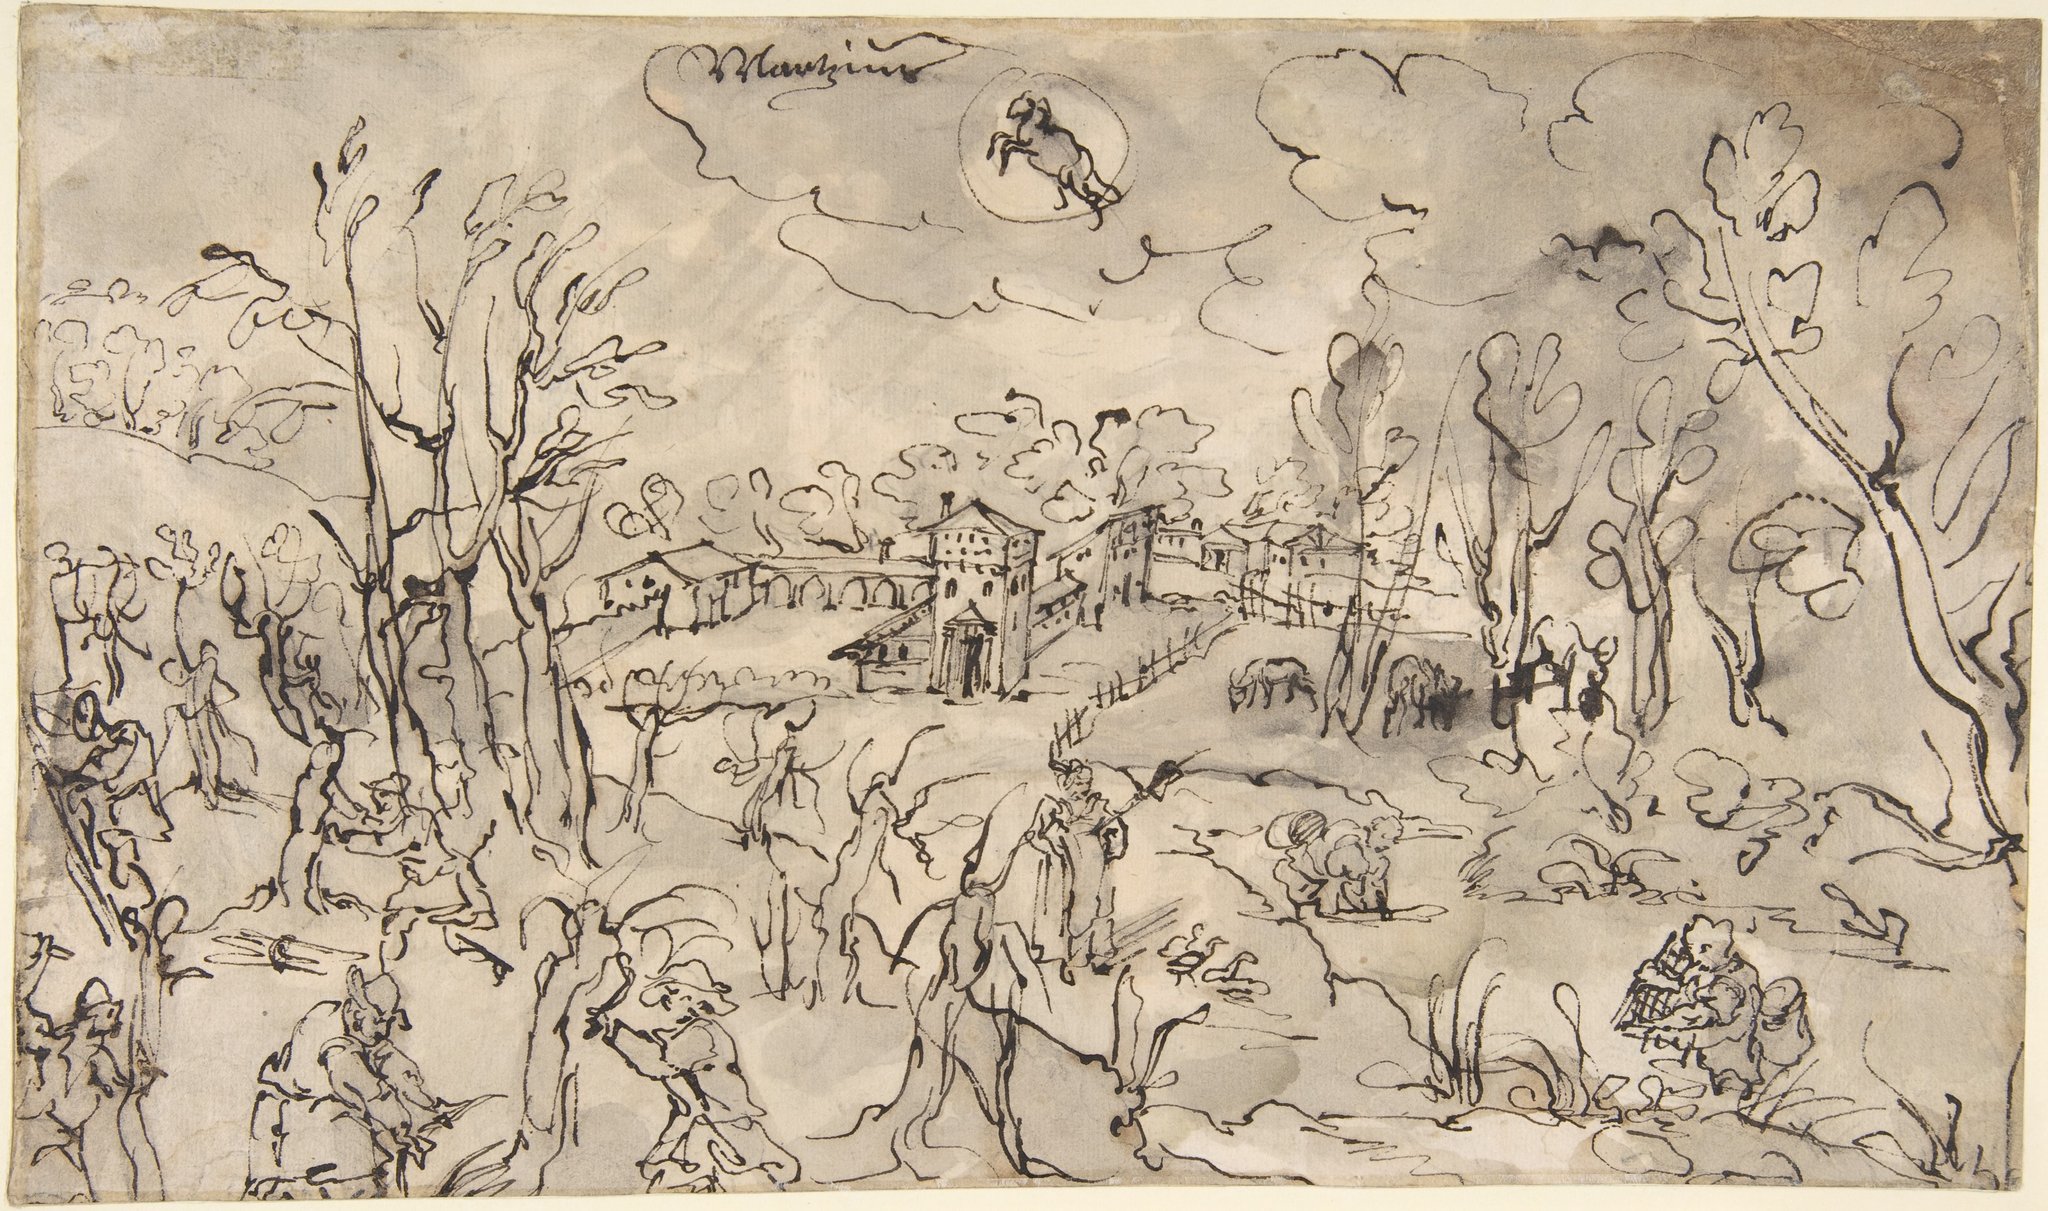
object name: drawing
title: Landscape with Figures Trimming Trees, an Allegory of the Month of March; Verso: Mountainous Landscape with Two Men Crossing a Bridge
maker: Anonymous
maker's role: artist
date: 1501-1600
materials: paint, chalk, ink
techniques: brush, heightening, pen, wash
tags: buildings,bridges,men,landscapes